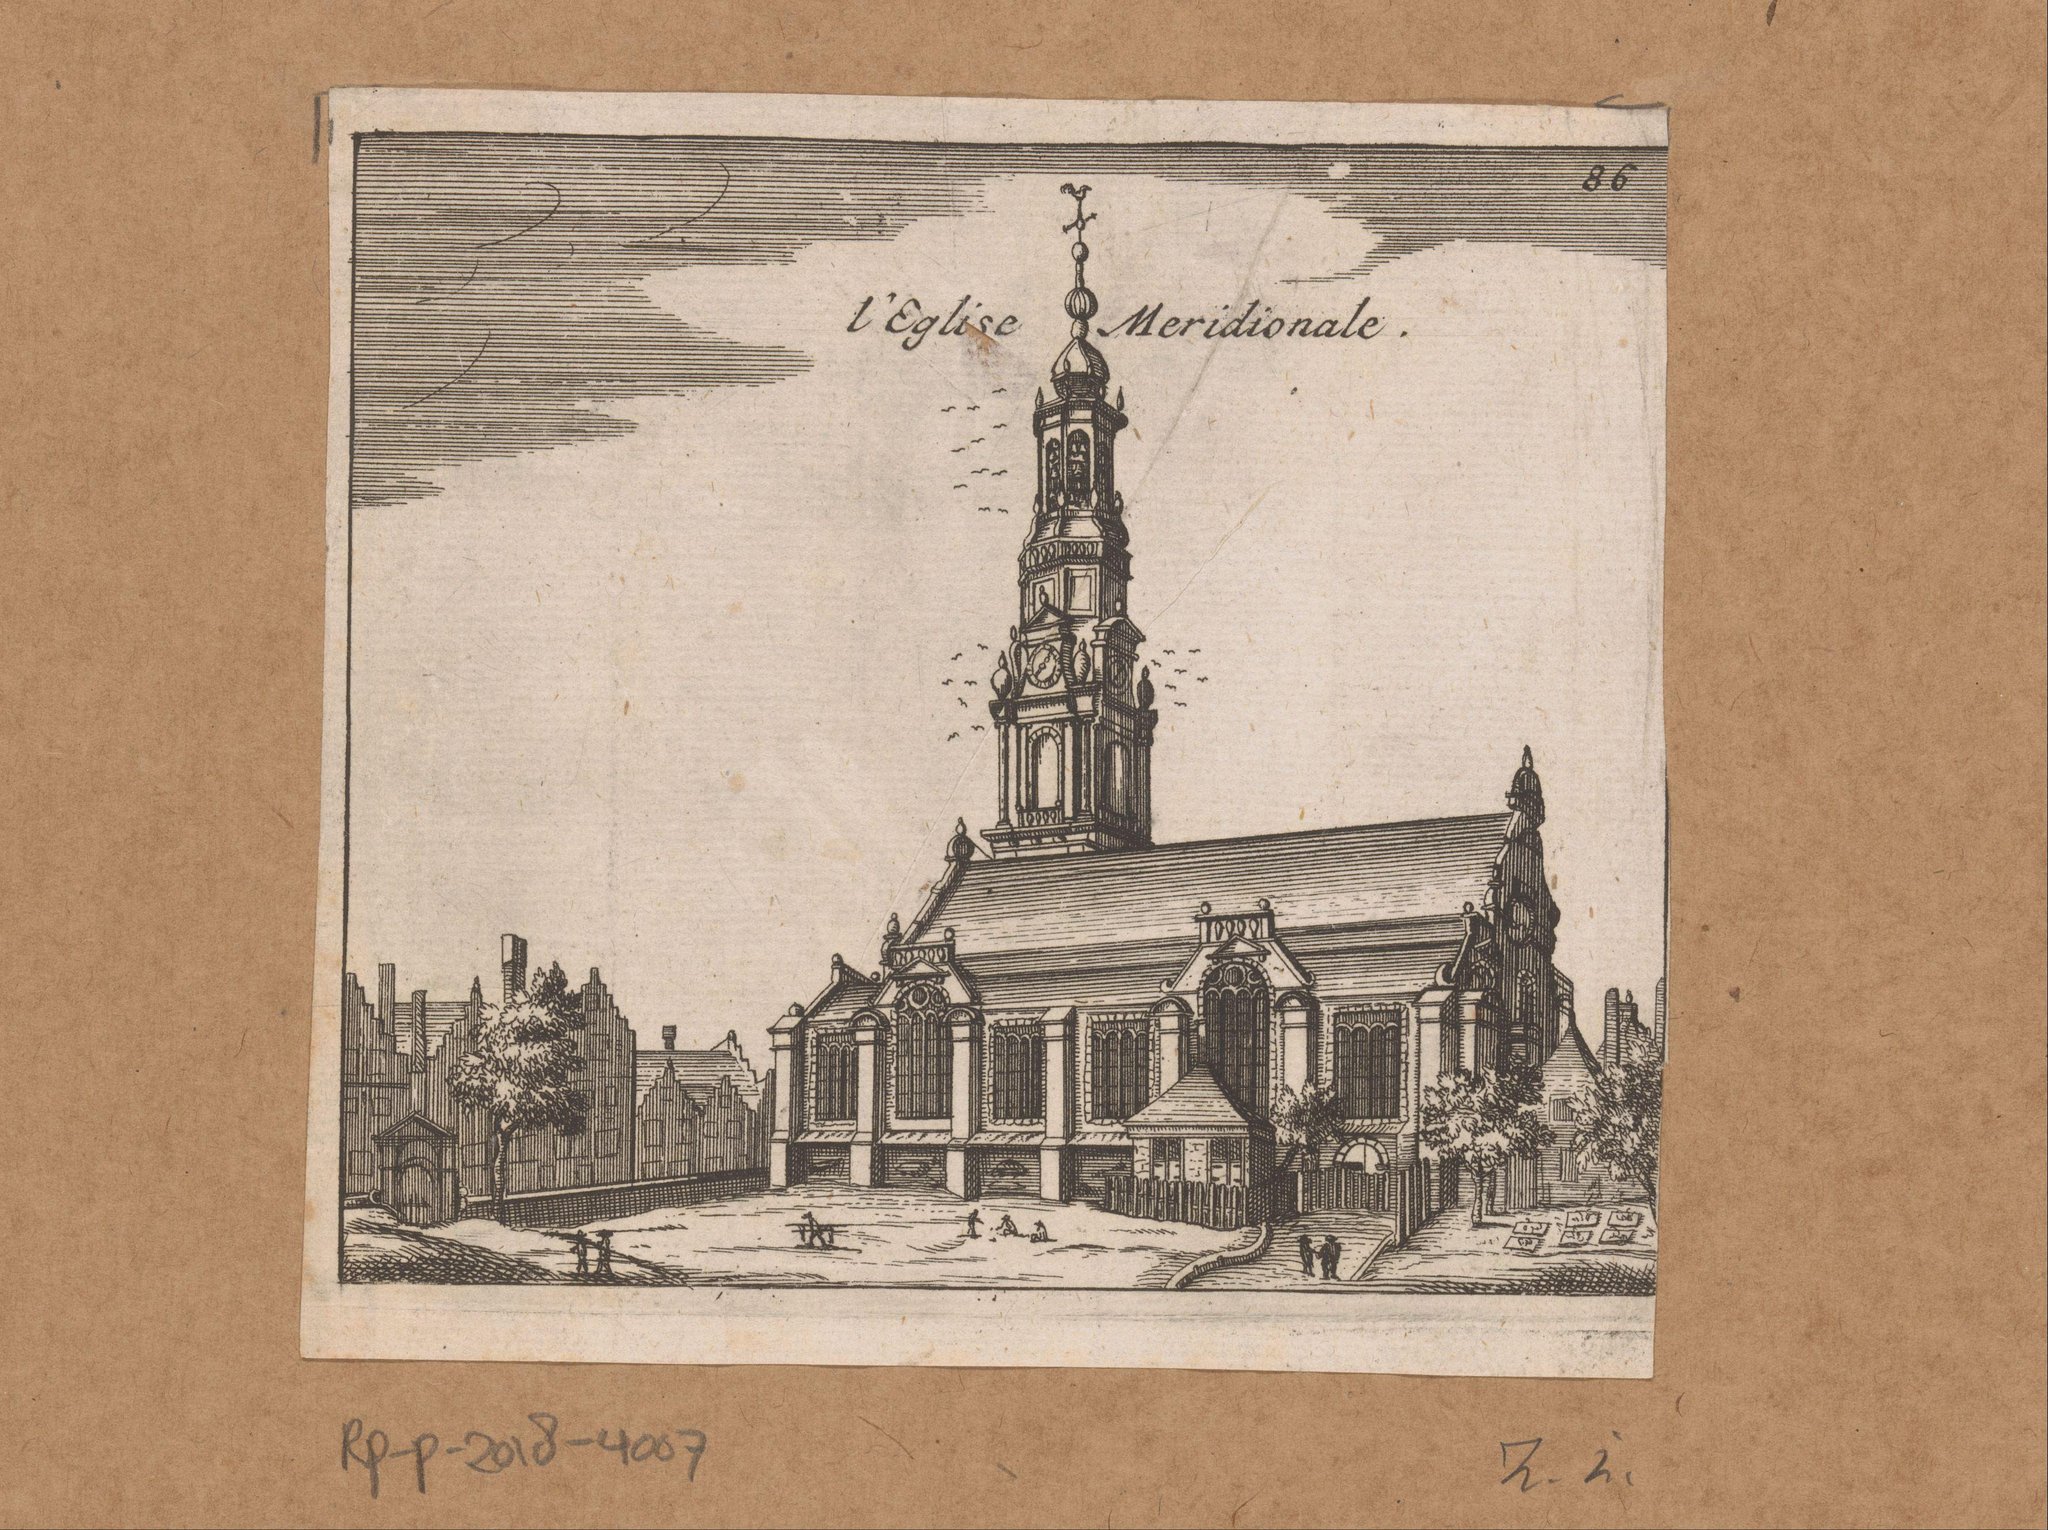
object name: print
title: L'Eglise Meridionale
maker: Anonymous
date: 1650-1700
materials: paper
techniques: etching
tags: church (exterior)